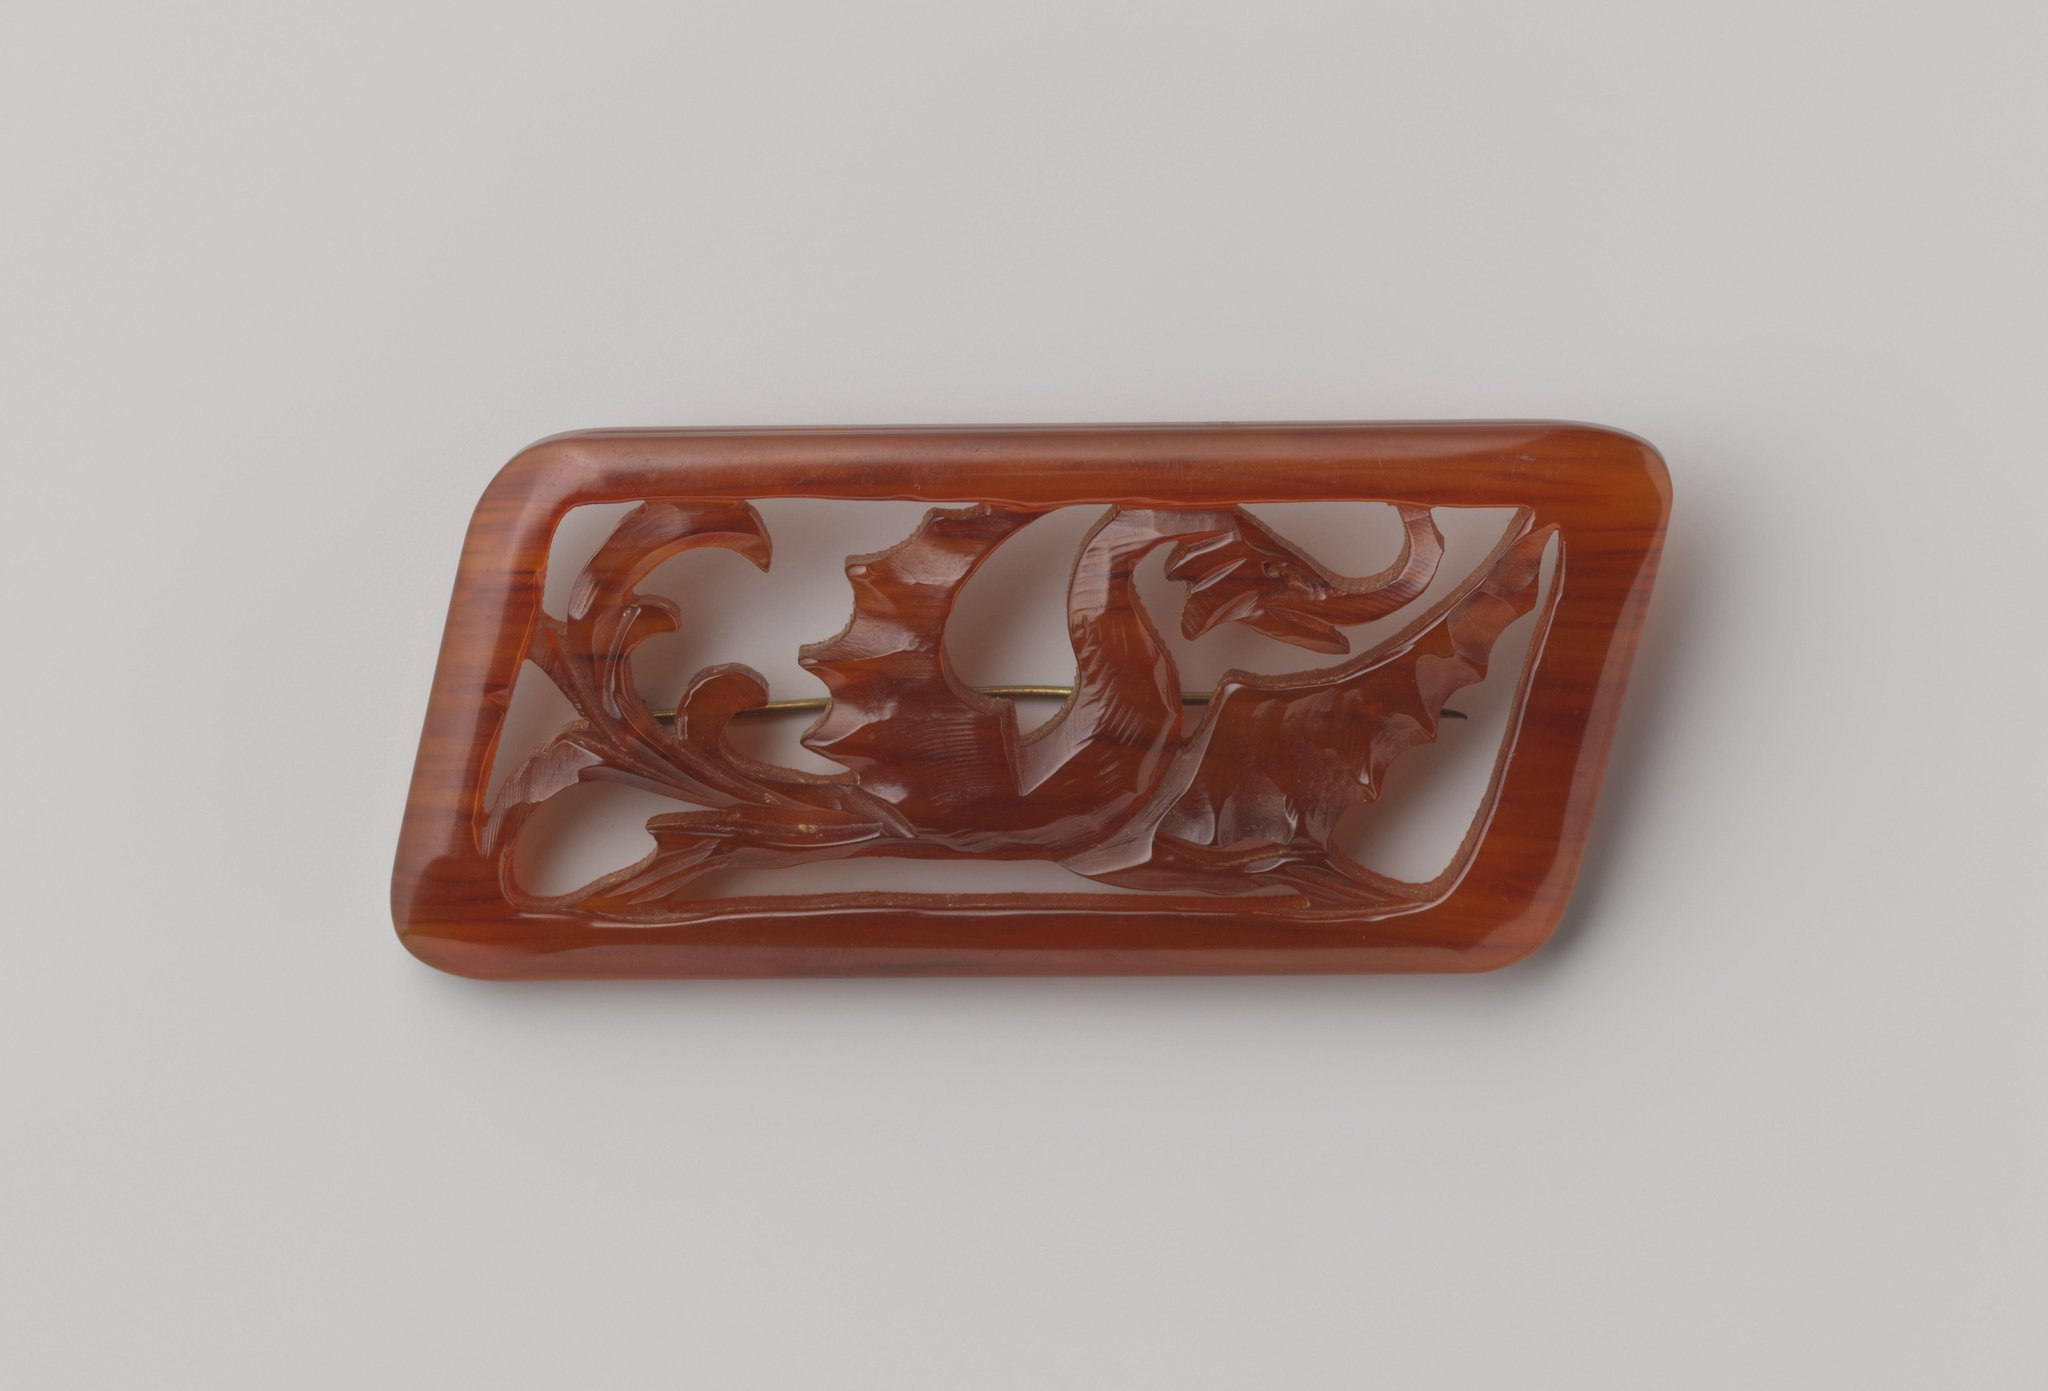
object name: buckle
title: Gesp 'Draak'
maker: Anonymous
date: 1900-1999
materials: amber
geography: netherlands